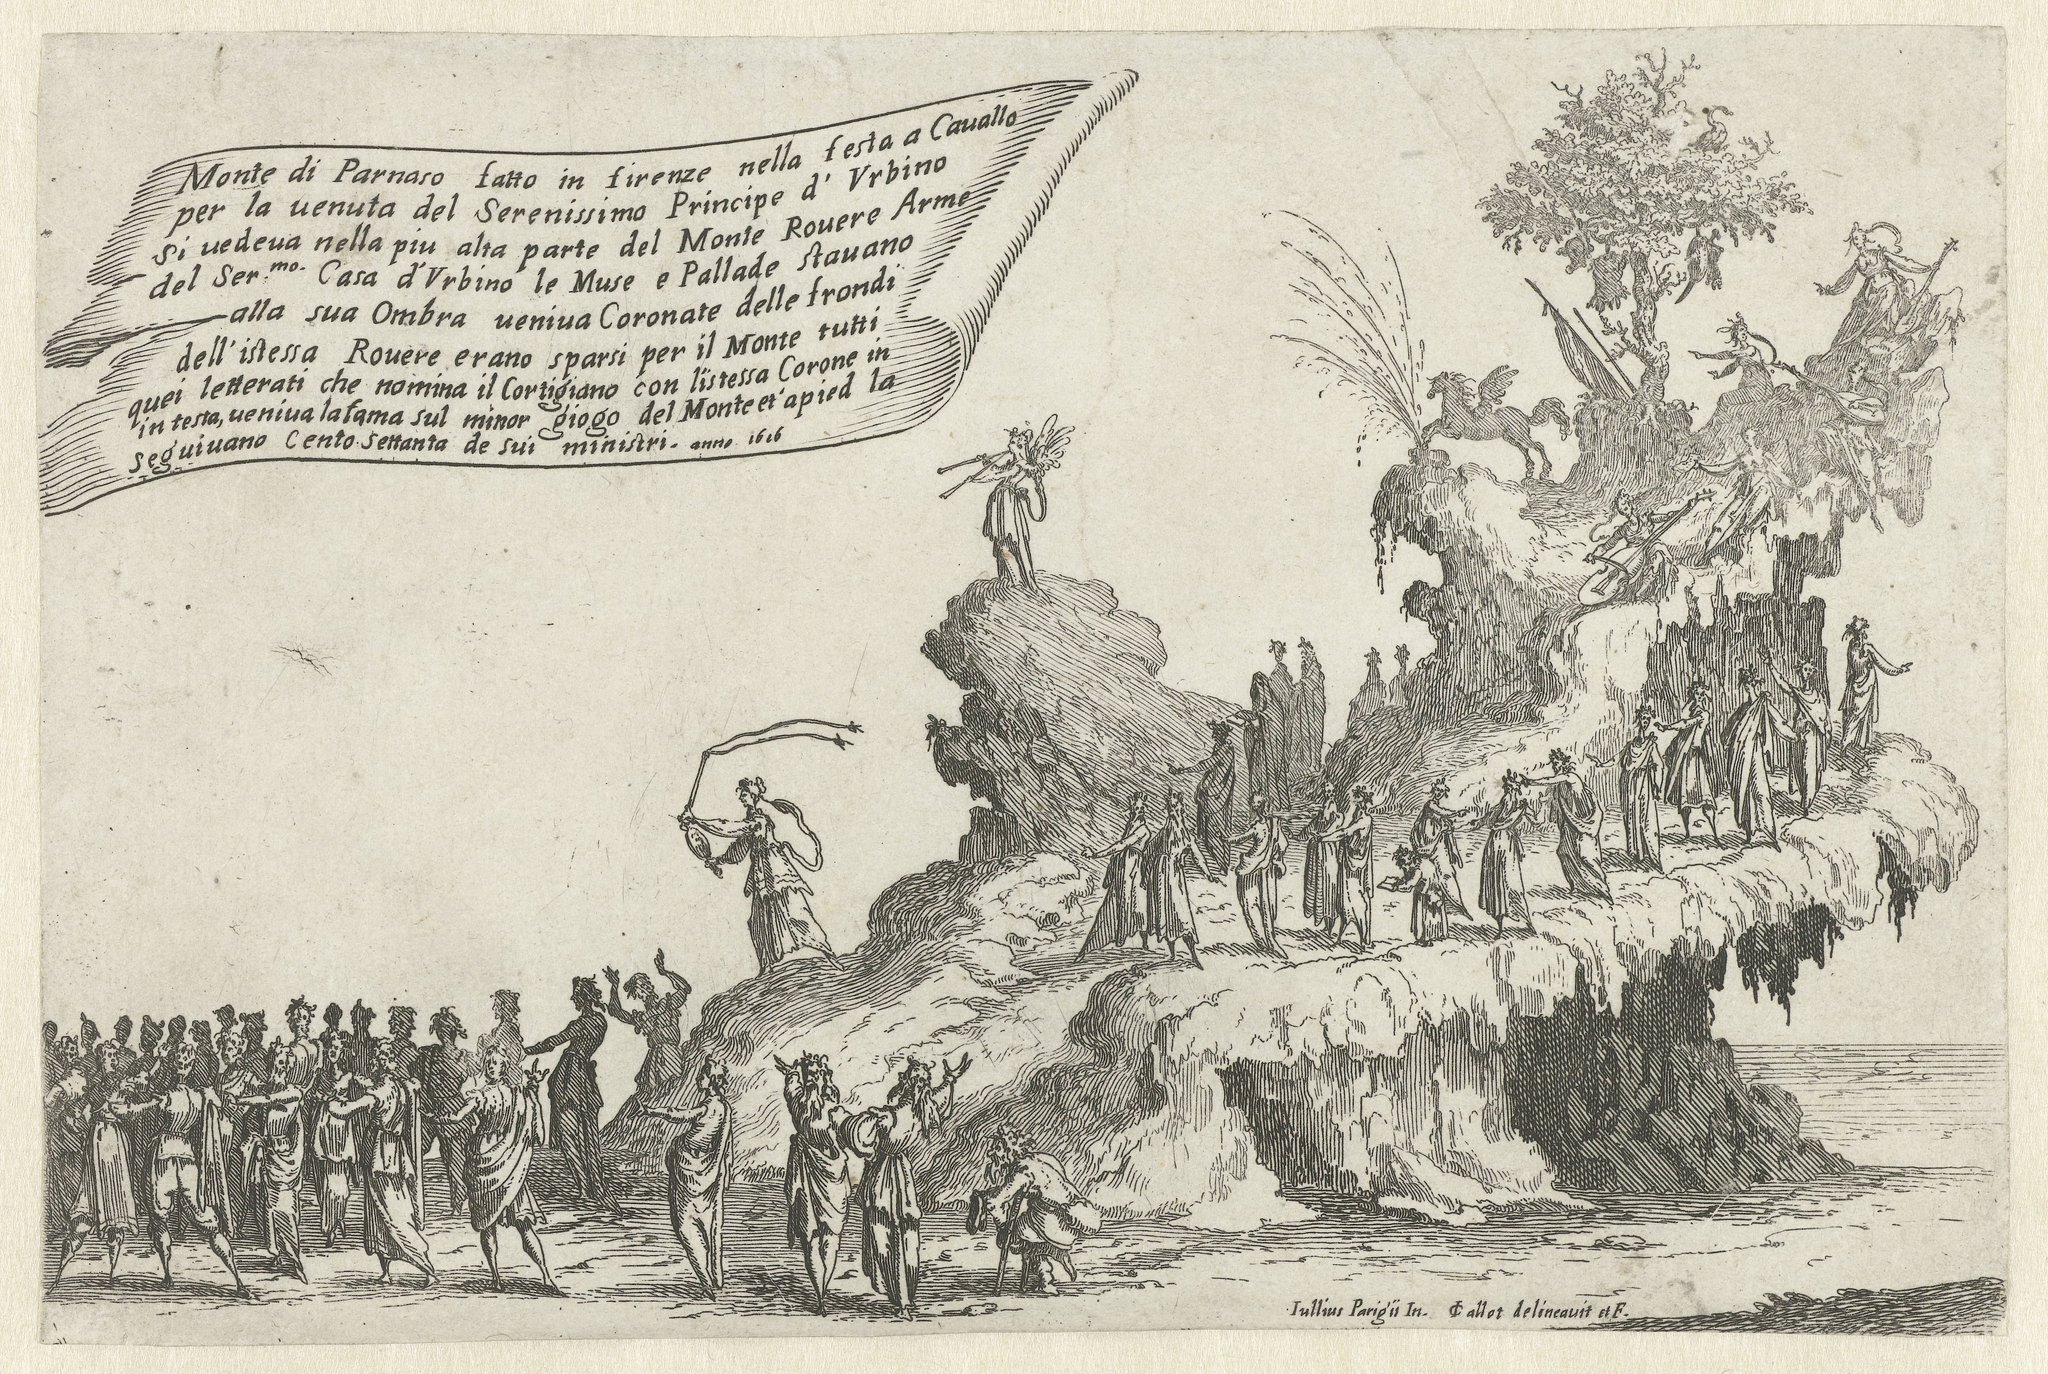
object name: print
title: Feest te Florence: praalwagen met de berg Parnassus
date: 1616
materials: paper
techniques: etching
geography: florence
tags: cosimo ii de' medici, chariot, triumphal car, parnassus, sacred to apollo musagetes, fama as roman personification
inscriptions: collector's mark: Lugt 240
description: Praalwagen in de vorm van de berg Parnassus, met daarop onder andere het paard Pegasus, muzikanten en de Faam. Dit bouwwerk werd vervaardigd voor het feest 'Guerra di Bellezza', dat Cosimo II de' Medici in 1616 in Florence gaf ter gelegenheid van de komst van Federico della Rovere, de vorst van Urbino en de verloofde van zijn zus Claudia. Bovenin de voorstelling een banier met Italiaanse tekst.